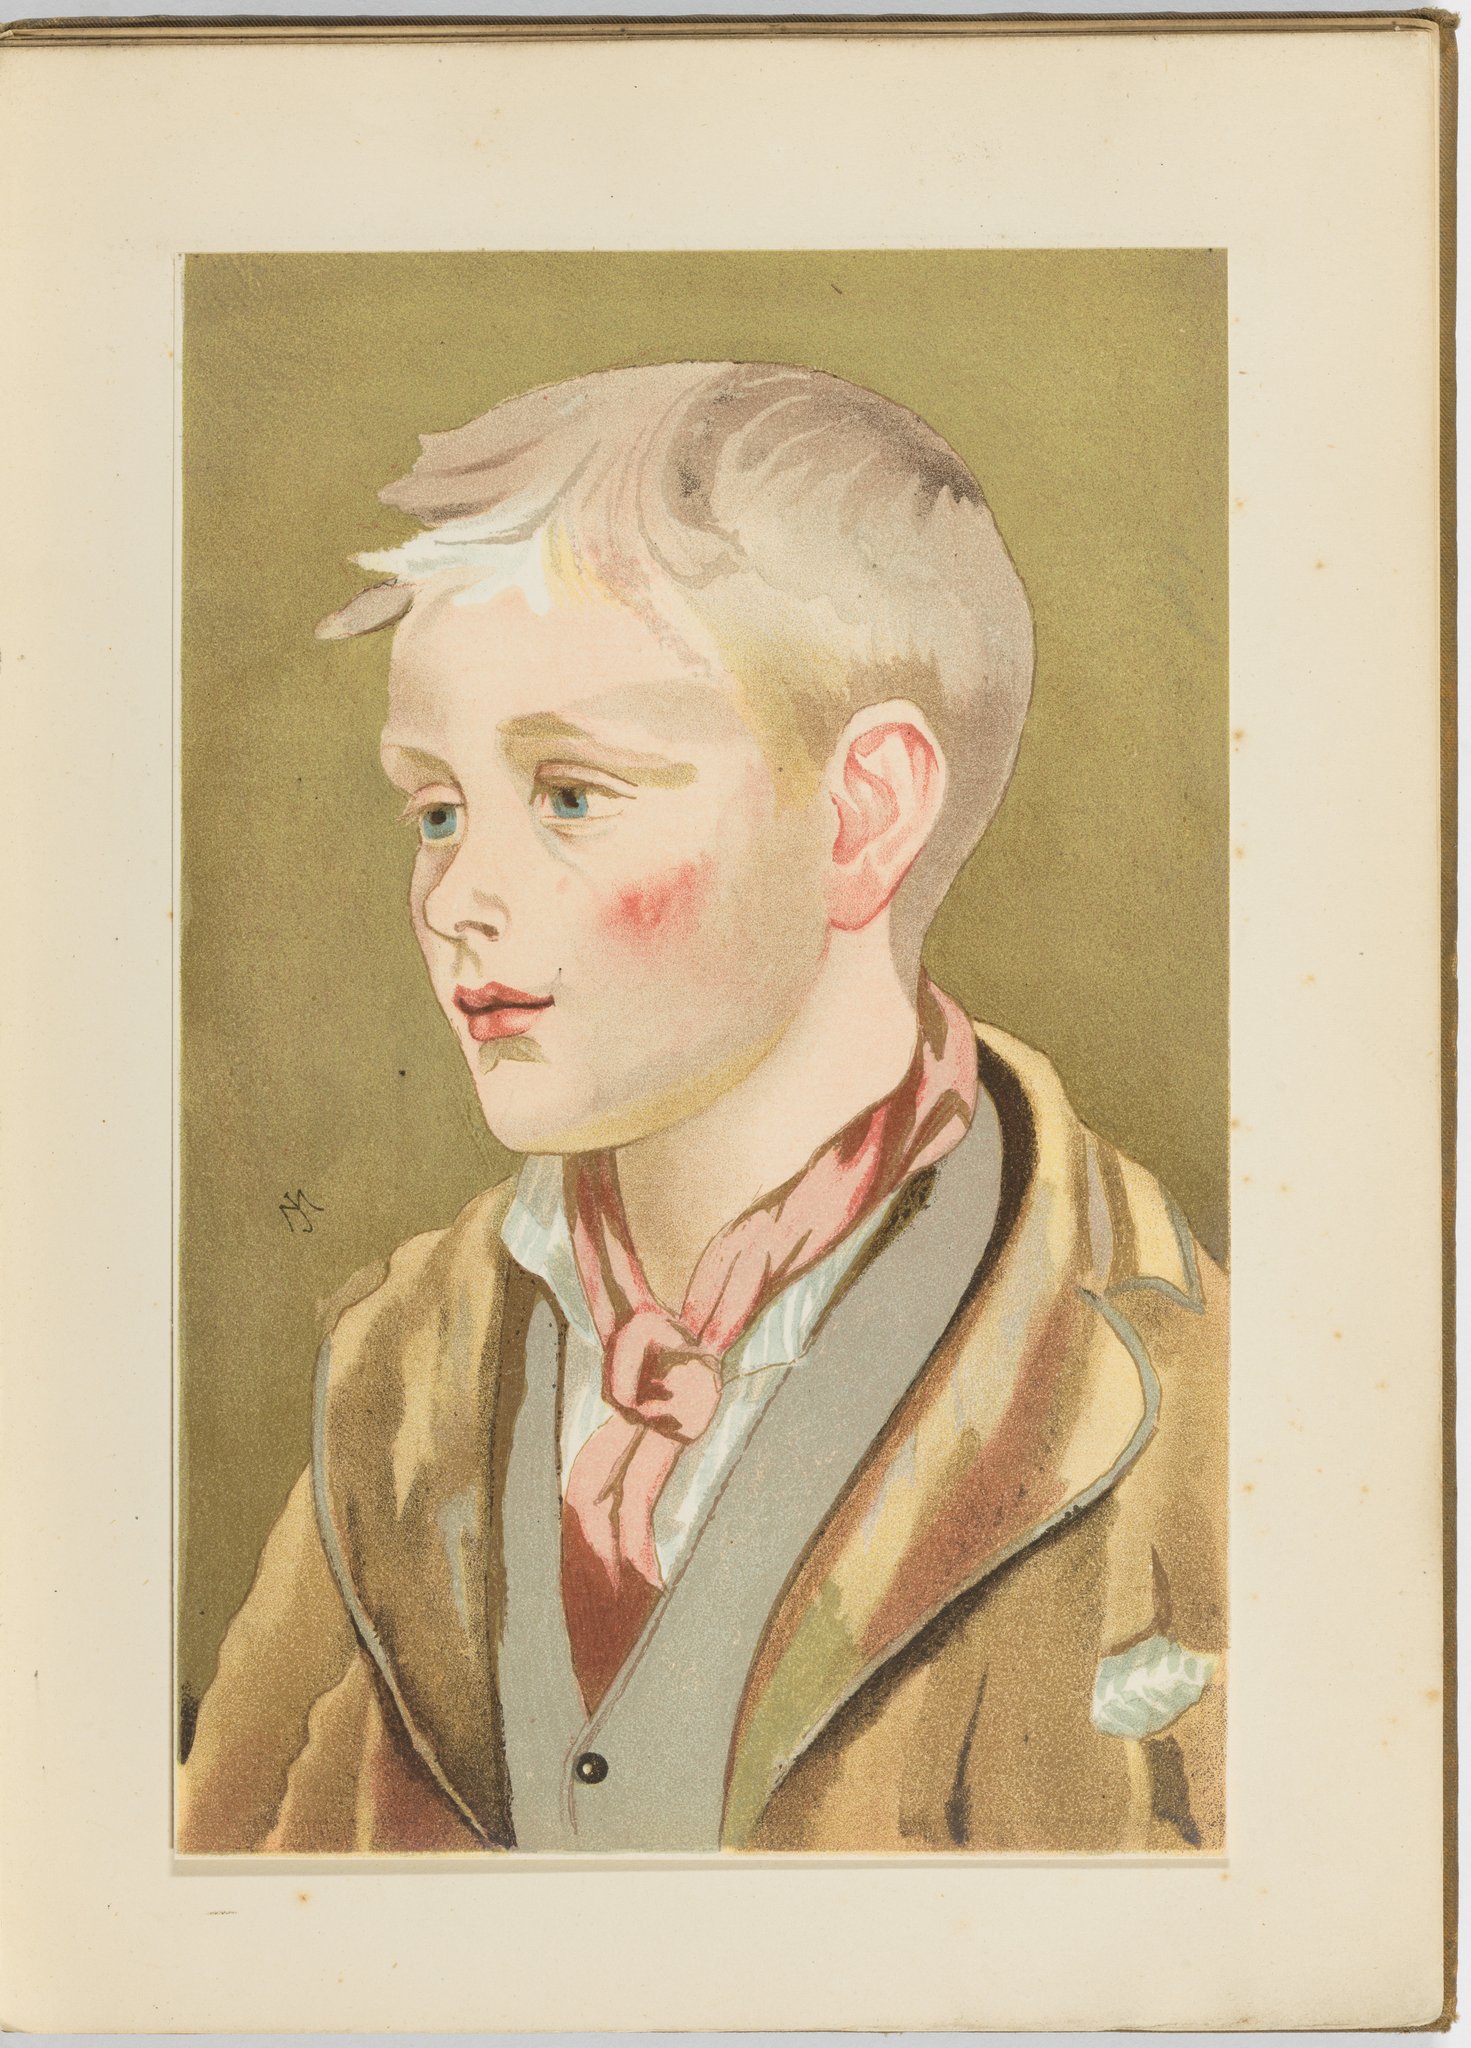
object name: book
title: Lessons in Figure Painting in Water Colours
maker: blanche f. macarthur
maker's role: author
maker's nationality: british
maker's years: 1847-1903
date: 1880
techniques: lithograph